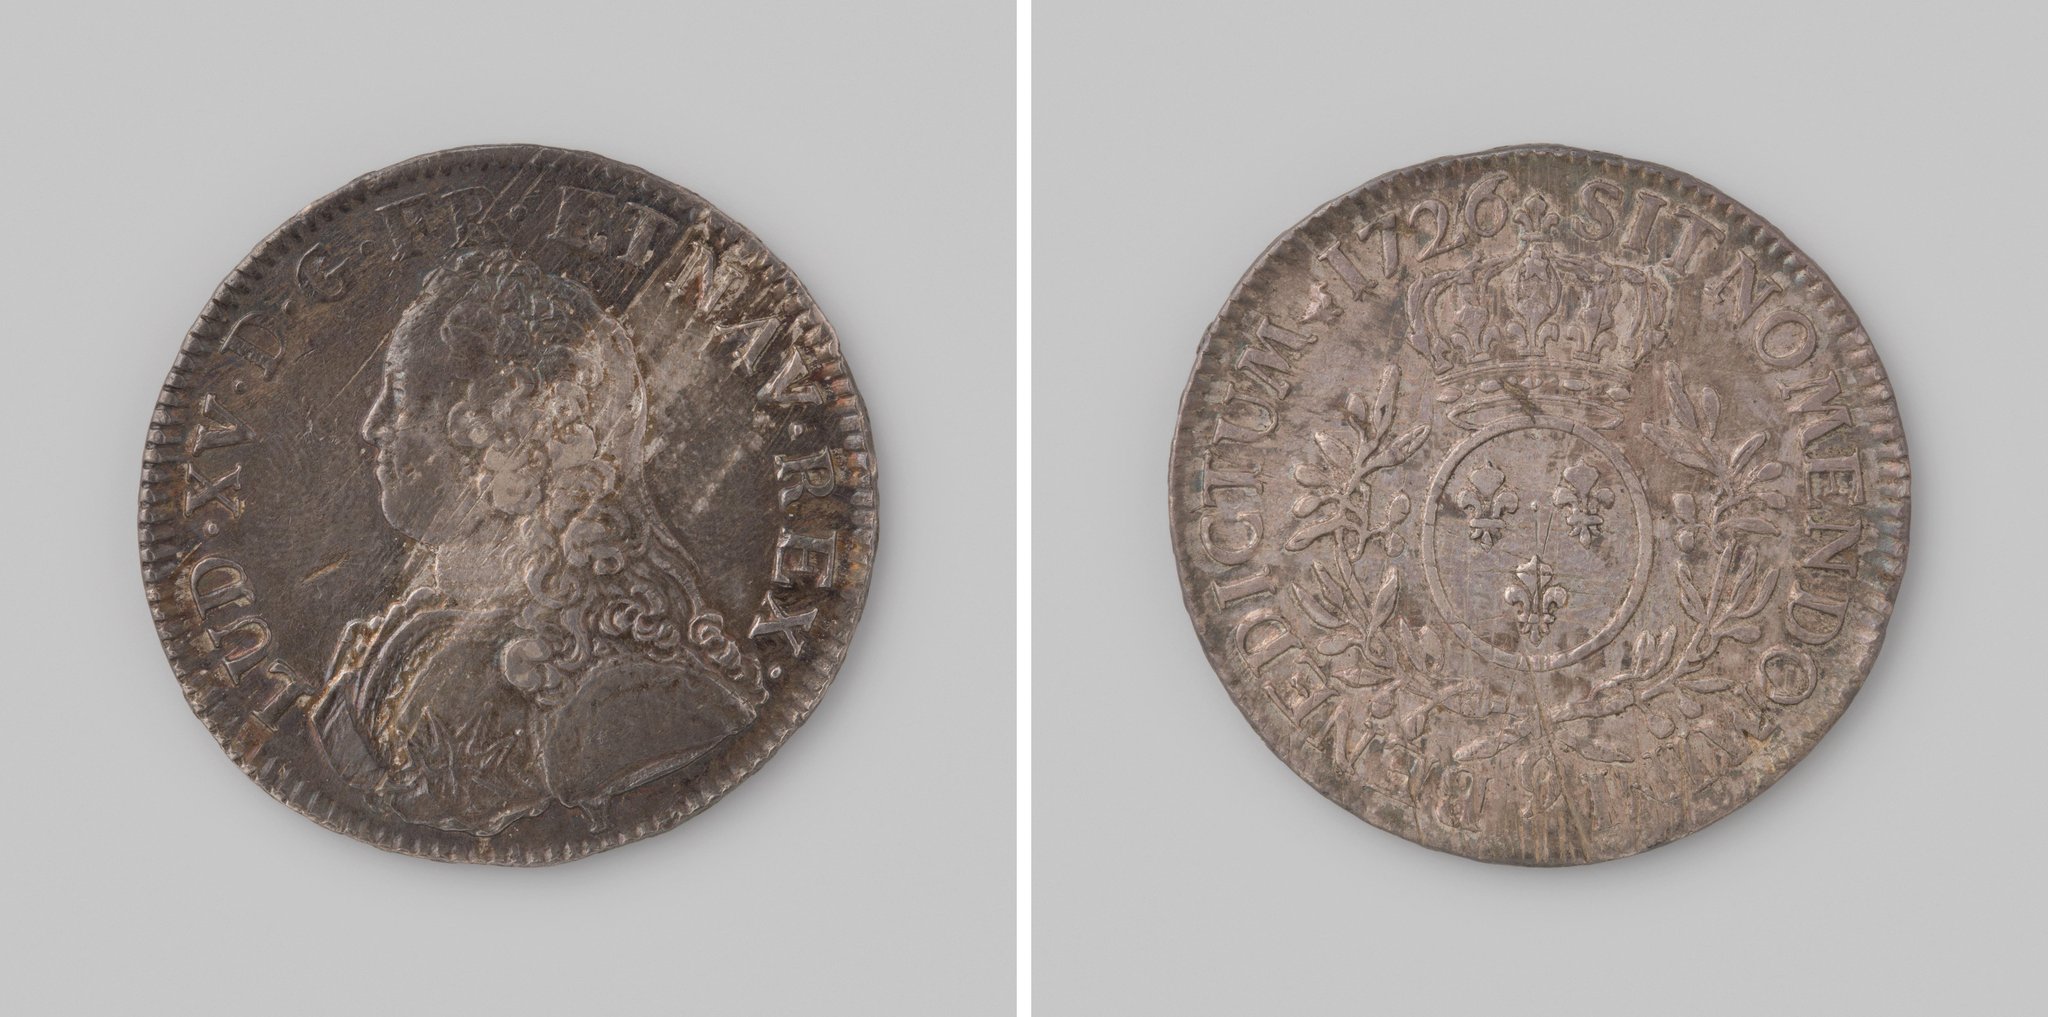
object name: coin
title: Frankrijk, écu blanc, Lodewijk XV, 1726 9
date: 1726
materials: silver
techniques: striking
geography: rennes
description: Zilveren munt. Voorzijde: borstbeeld van de koning naar links. Keerzijde: tussen twee samengebonden takken gekroond wapenschild. Onderaan in omschrift cijfer 9 [=Rennes]. Jaartal aan eind van omschrift. Randschrift.